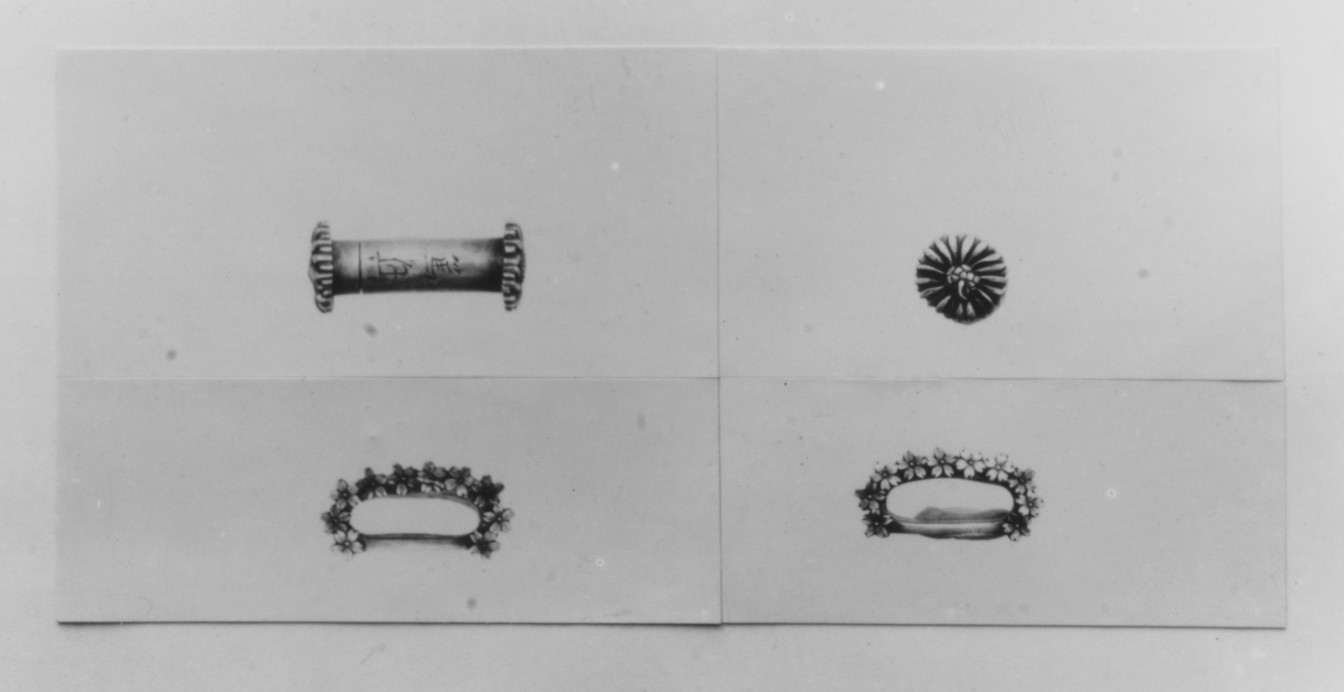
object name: sword grip ornament megugi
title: Sword Grip Ornament (Megugi)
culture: japanese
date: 1801-1900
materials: silver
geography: japan